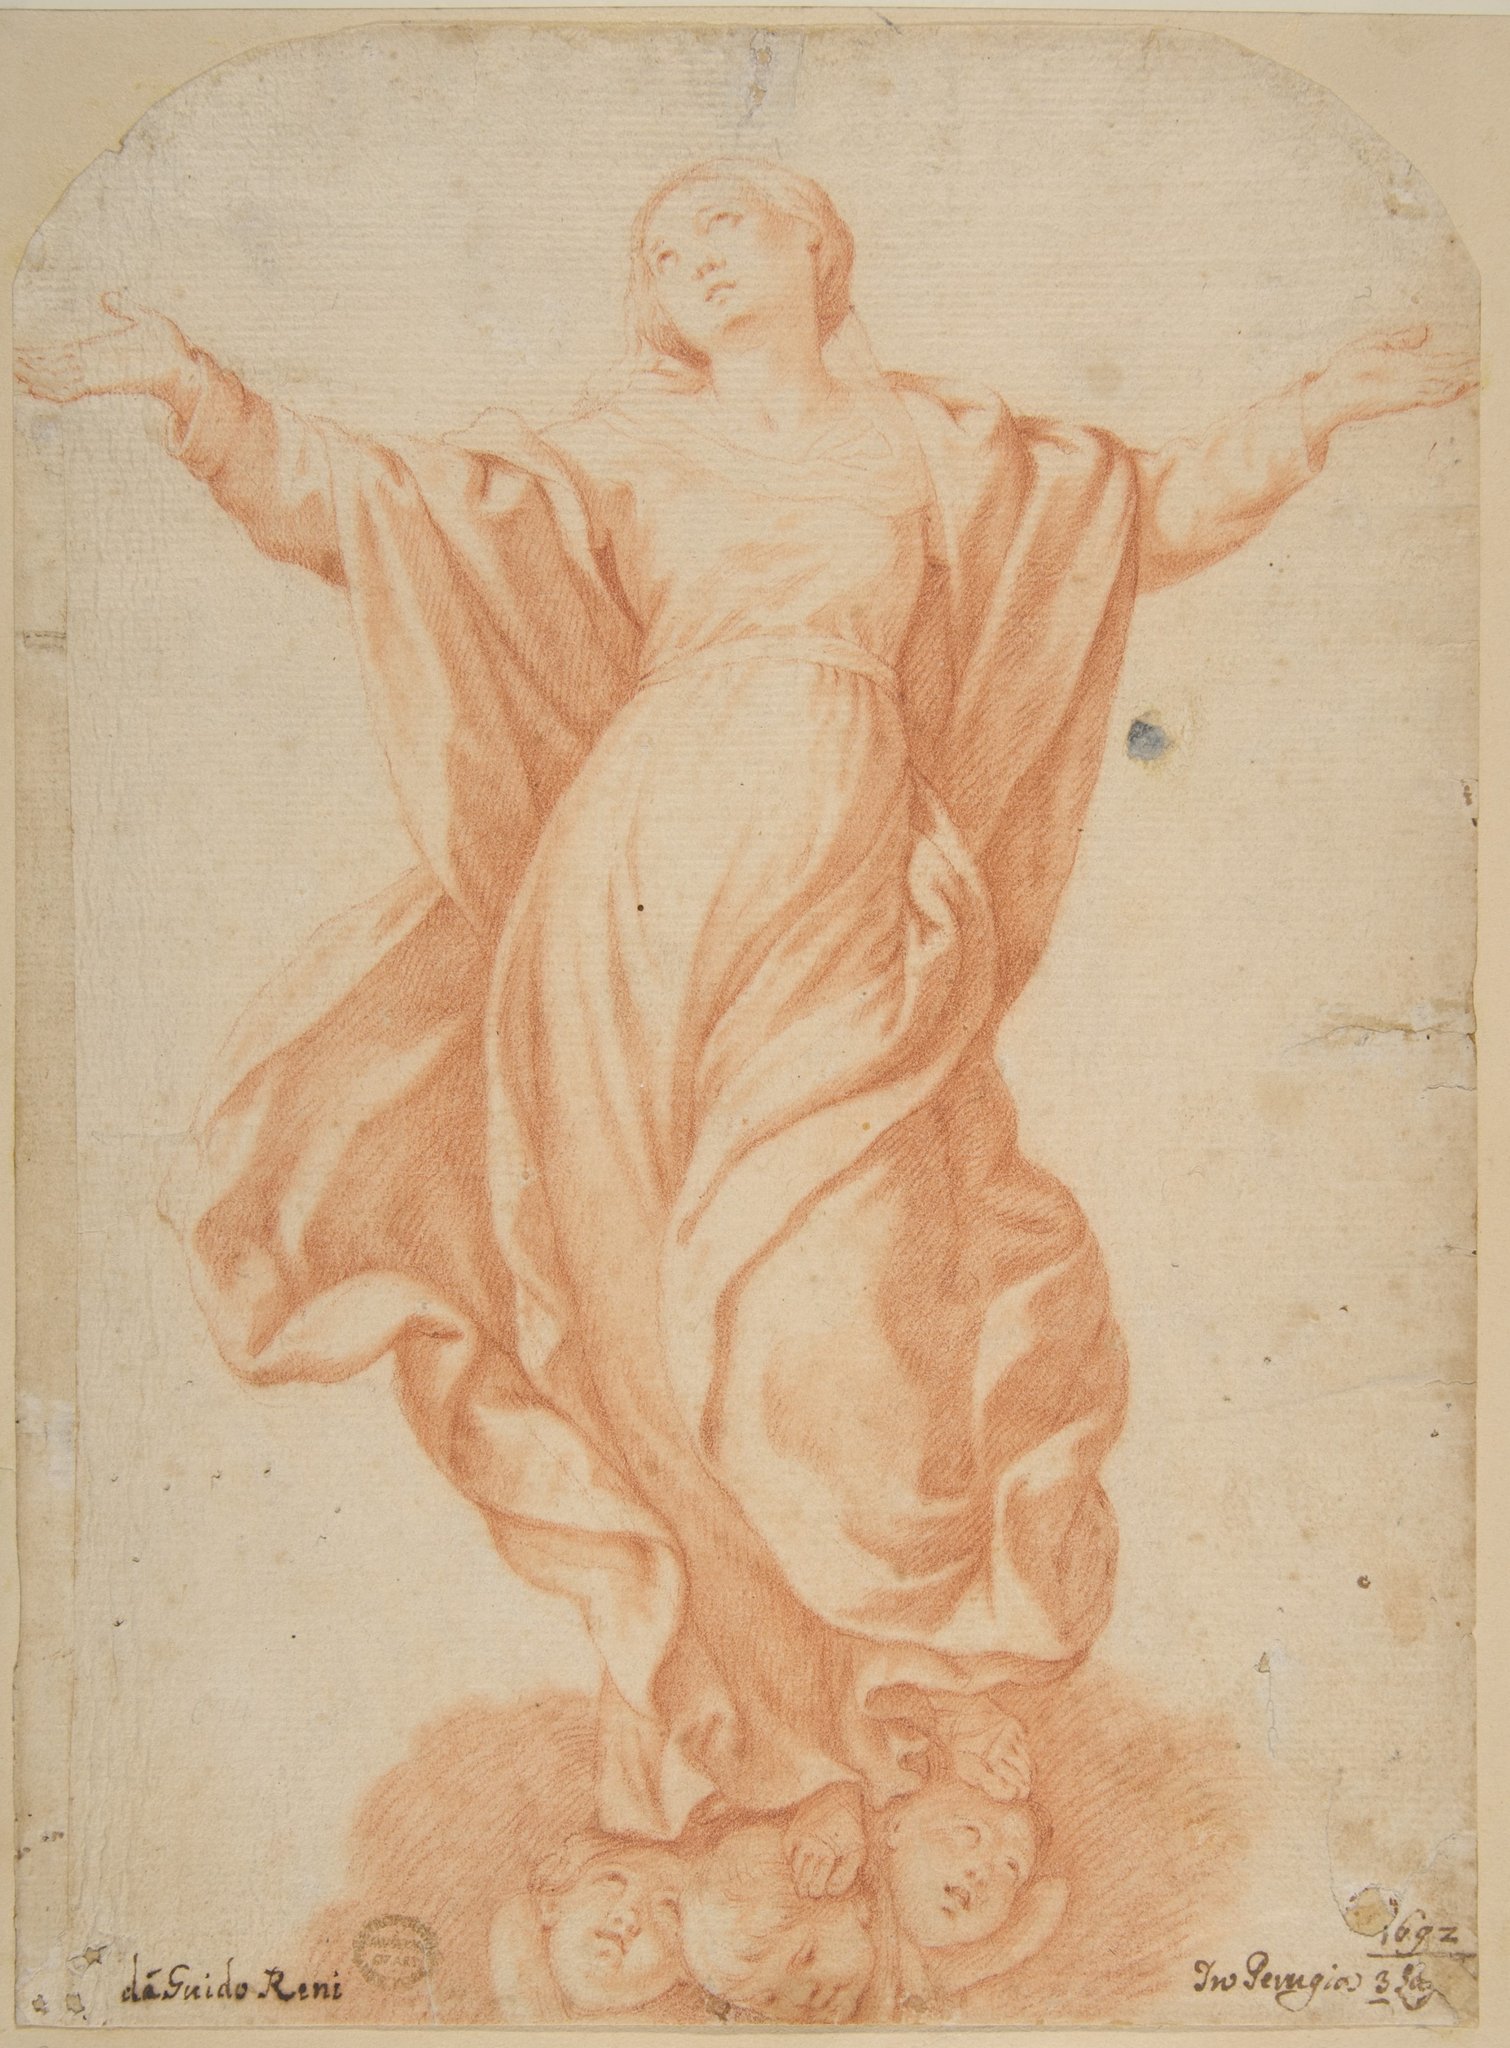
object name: drawing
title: Assumption of the Virgin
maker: guido reni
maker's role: artist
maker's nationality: italian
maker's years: 1575-1642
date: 1575-1642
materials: chalk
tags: assumption of the virgin